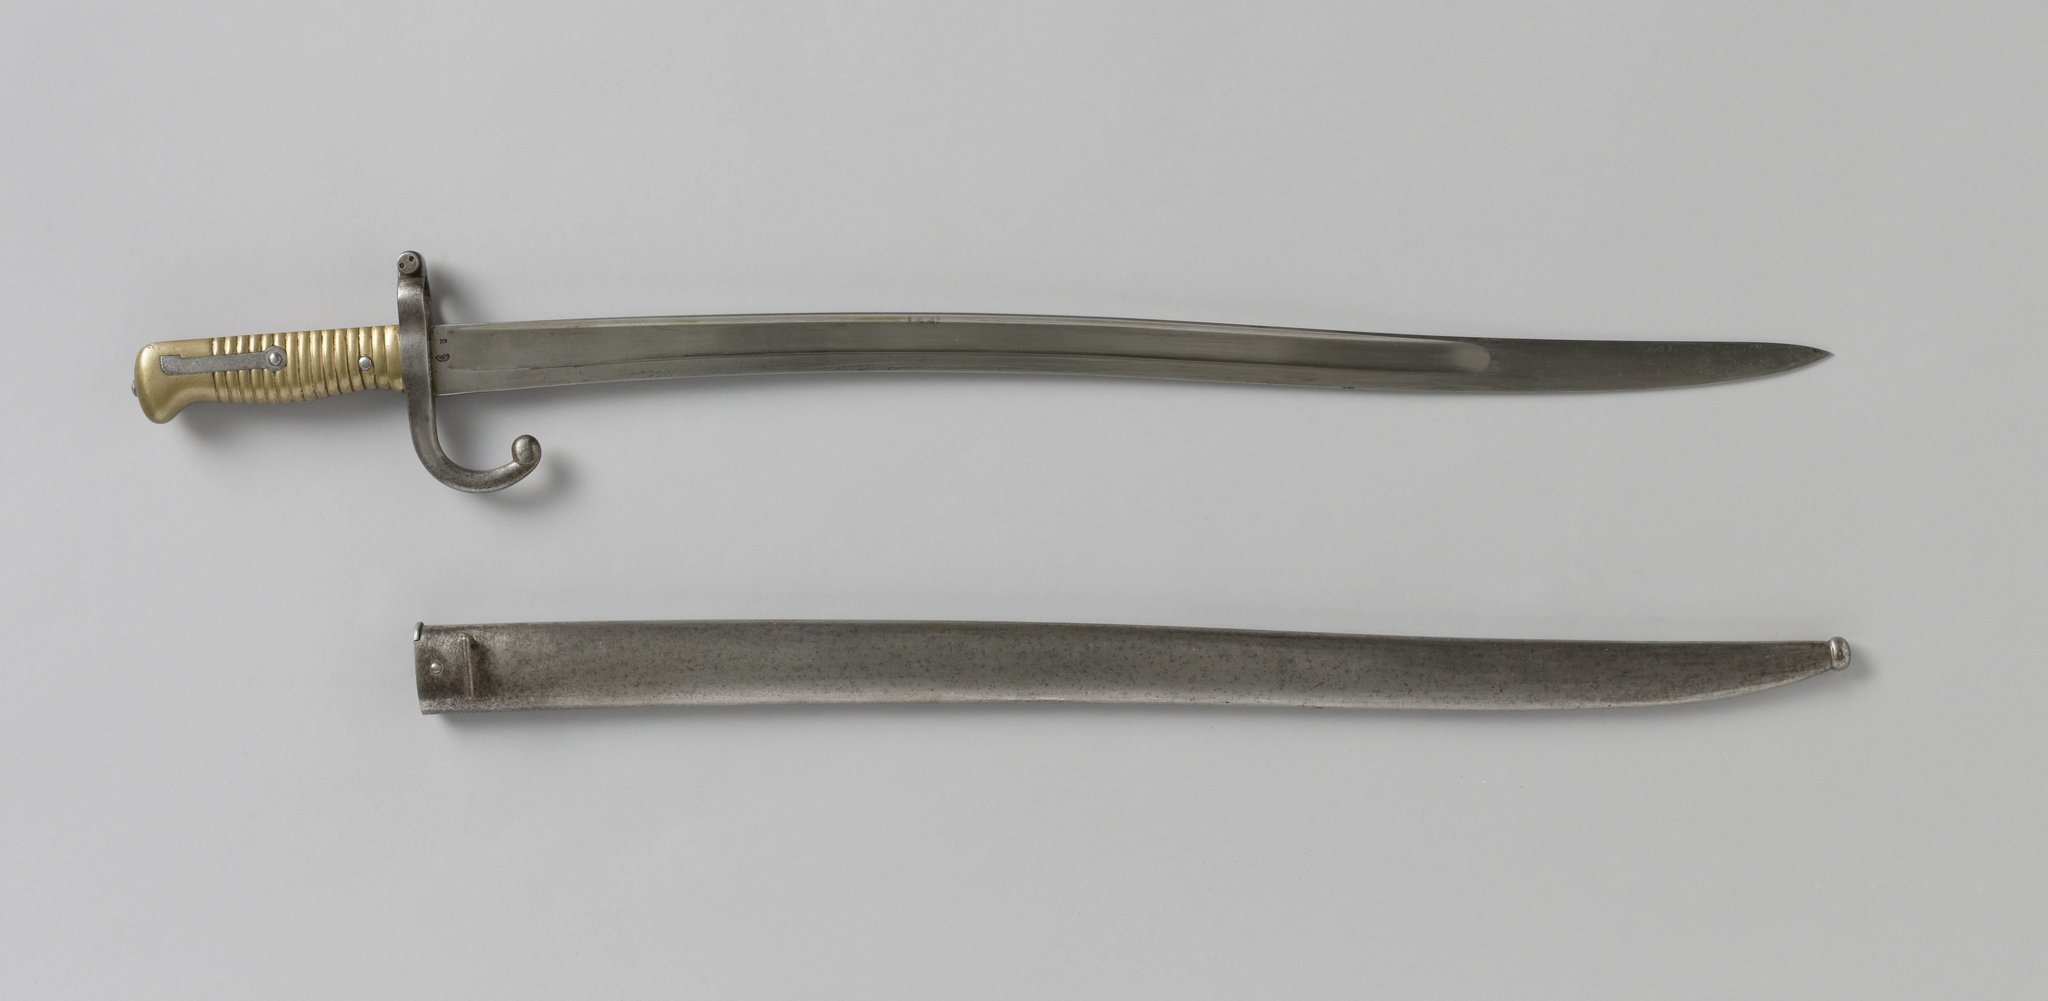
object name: sword bayonet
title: Bayonet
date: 1870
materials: brass, iron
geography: maastricht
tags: maastricht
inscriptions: mark: ‘M met kroon’, inscription: ‘42’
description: Sabelbajonet die aan een achterlaadgeweer met een Beaumont-systeem bevestigd kan worden. De bajonet heeft een ijzeren kling met messing gevest. De stootplaat heeft een pareerstang met neerwaarste knop. De greep van de bajonet is geribbeld. Behorende bij de bajonet een ijzeren schede.